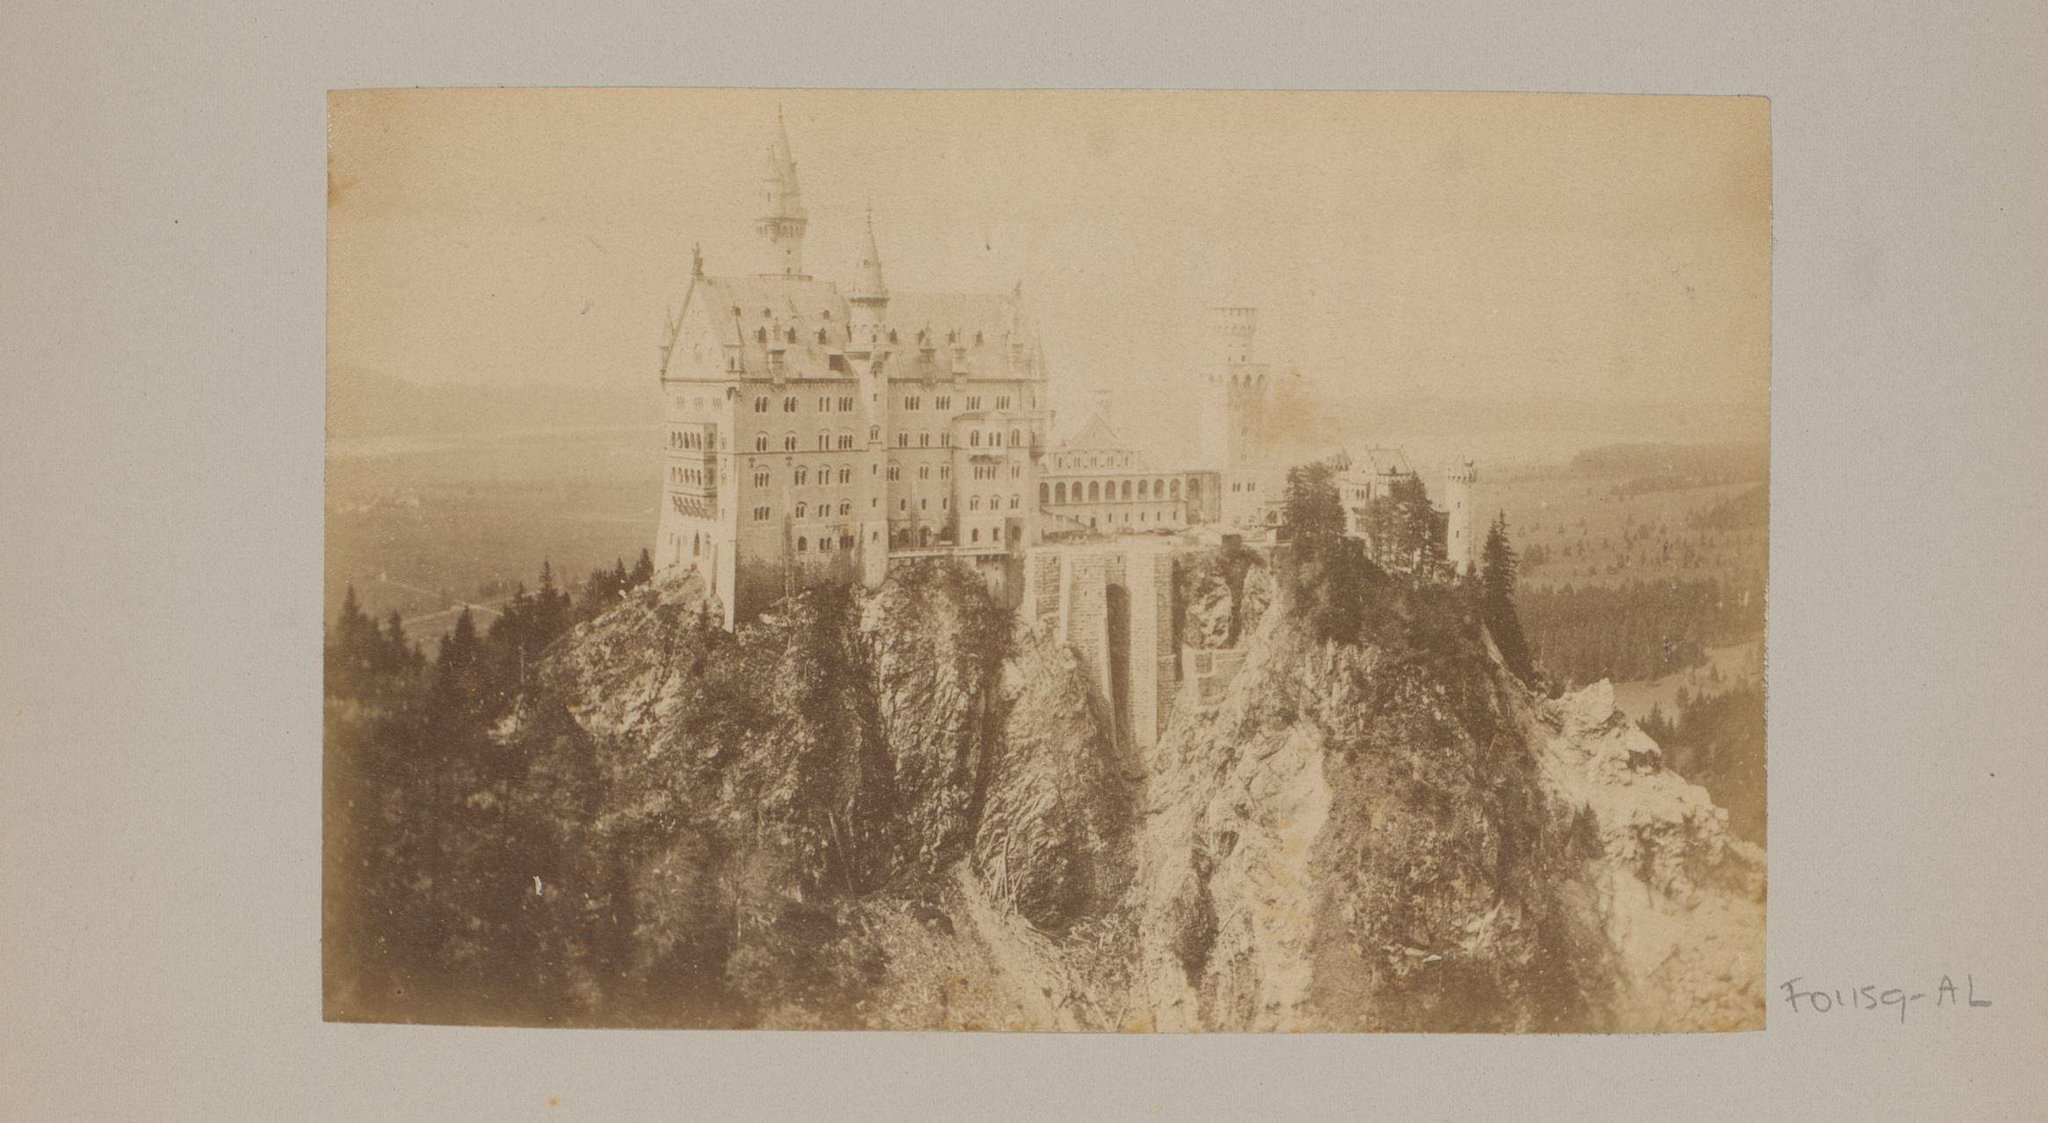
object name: photograph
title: Gezicht op slot Neuschwanstein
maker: Anonymous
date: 1880-1900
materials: photographic support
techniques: albumen print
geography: hohenschwangau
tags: castle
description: Onderdeel van Reisalbum met opnames van bezienswaardigheden in Zweden, Noorwegen, Denemarken, Beieren, Milaan en Parijs.